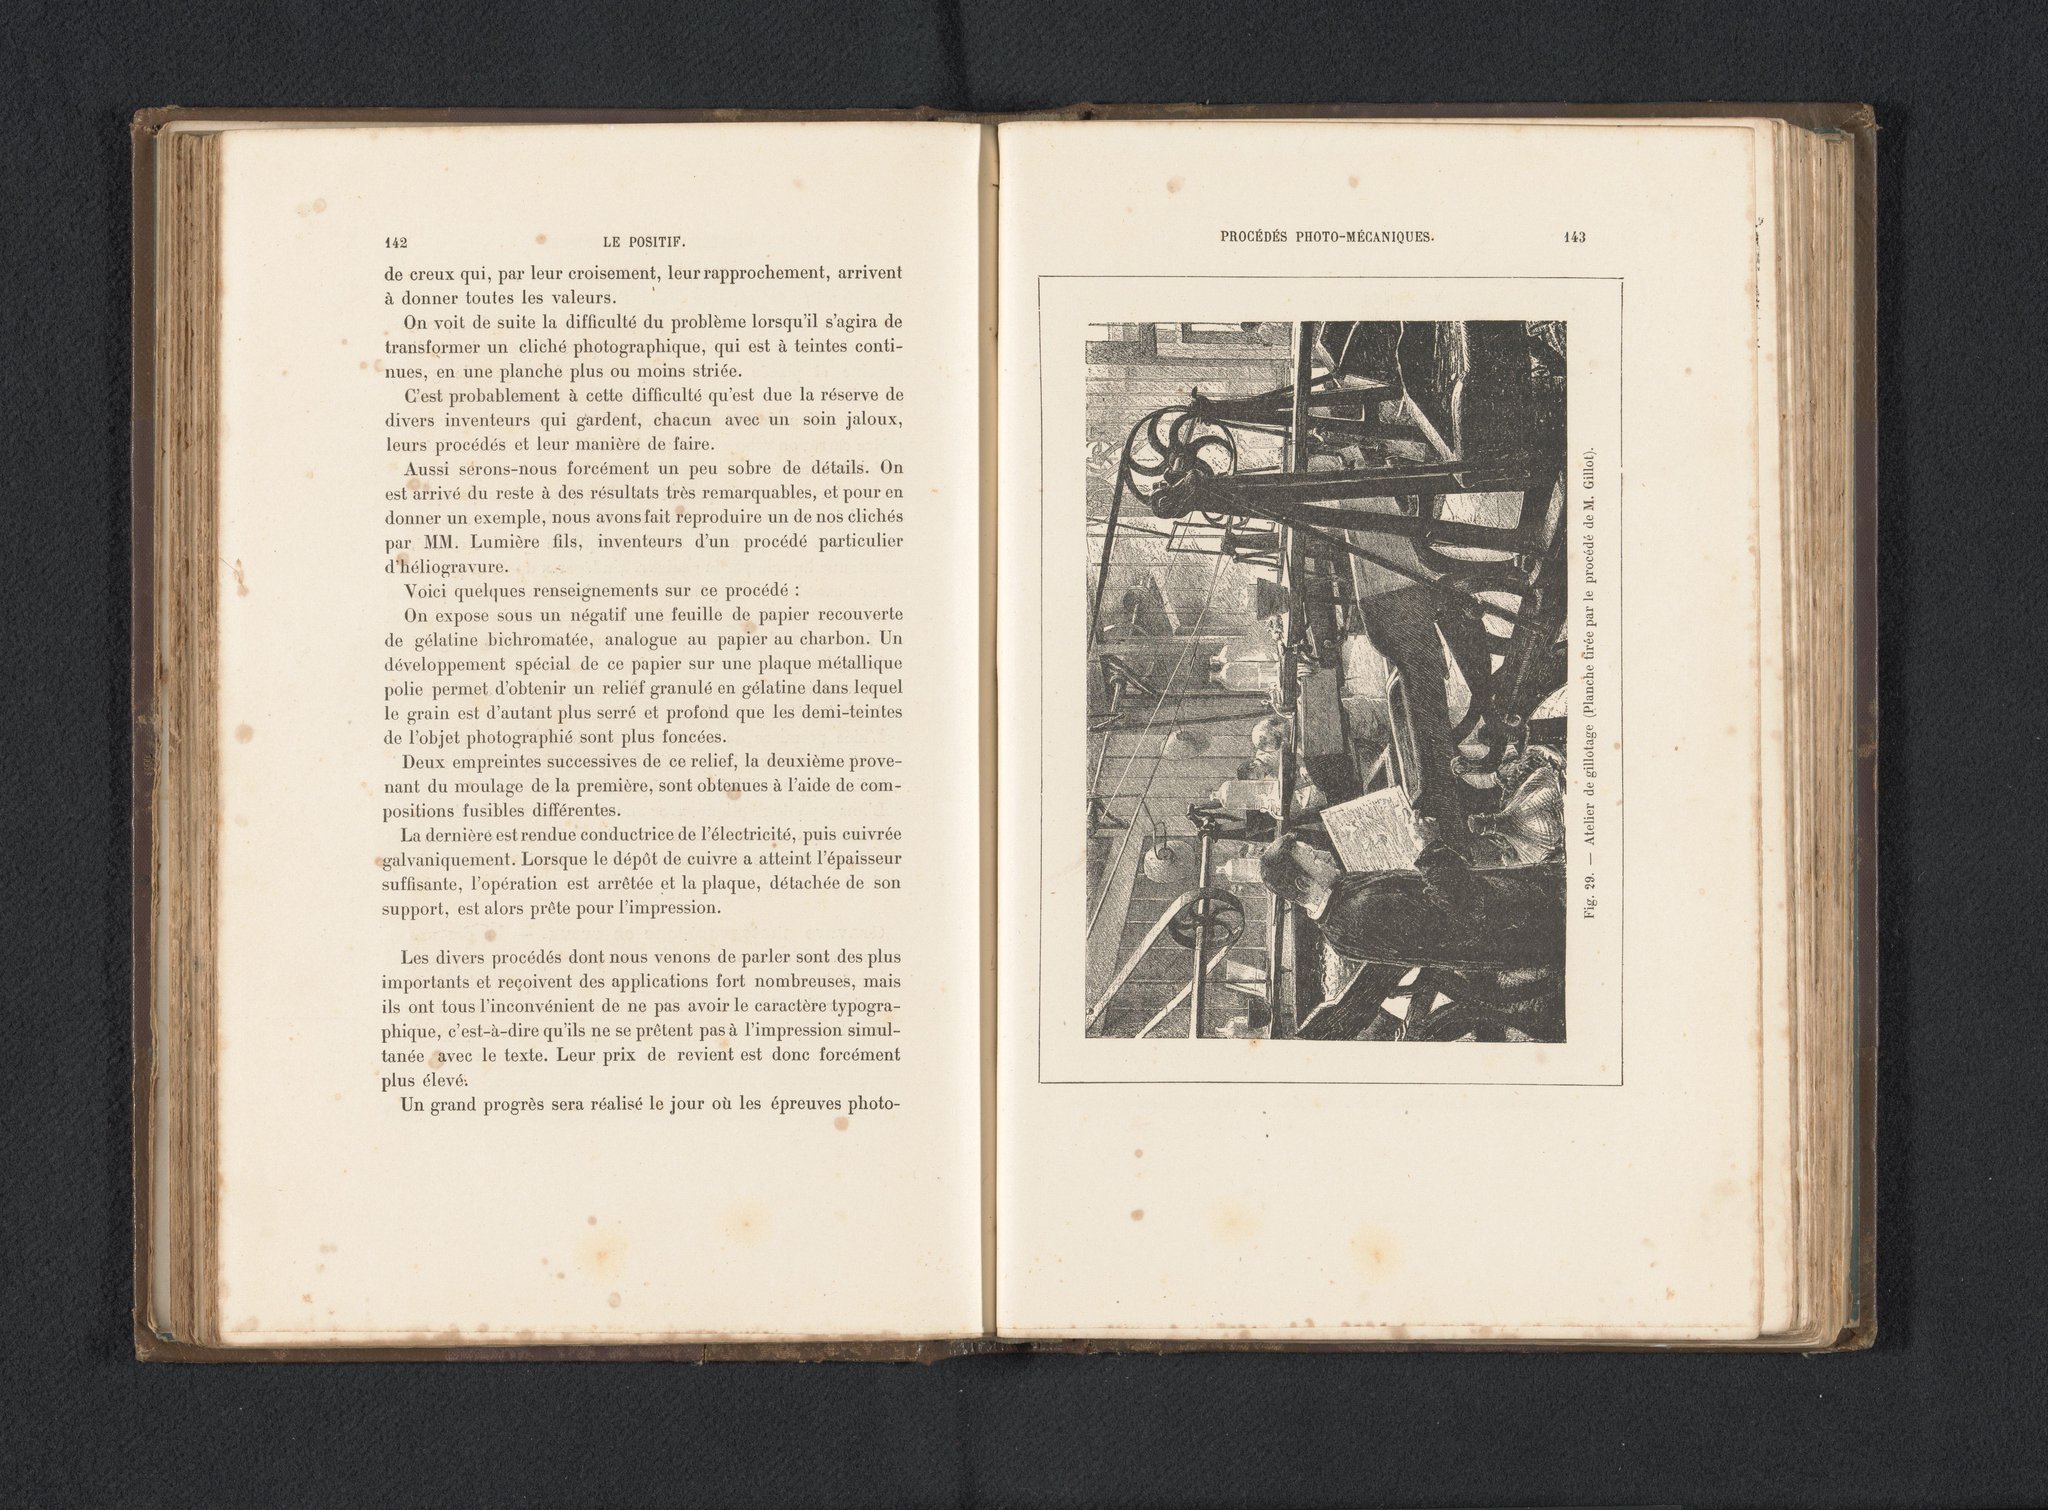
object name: photomechanical print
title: Atelier waar gillotage afdrukken worden gemaakt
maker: Anonymous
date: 1883-1888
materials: paper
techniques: gillotage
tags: workshop-interior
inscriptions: inscription: ‘Fig. 29. - Atelier de gillotage (Planche tirée par le procédé de M. Gillot).’